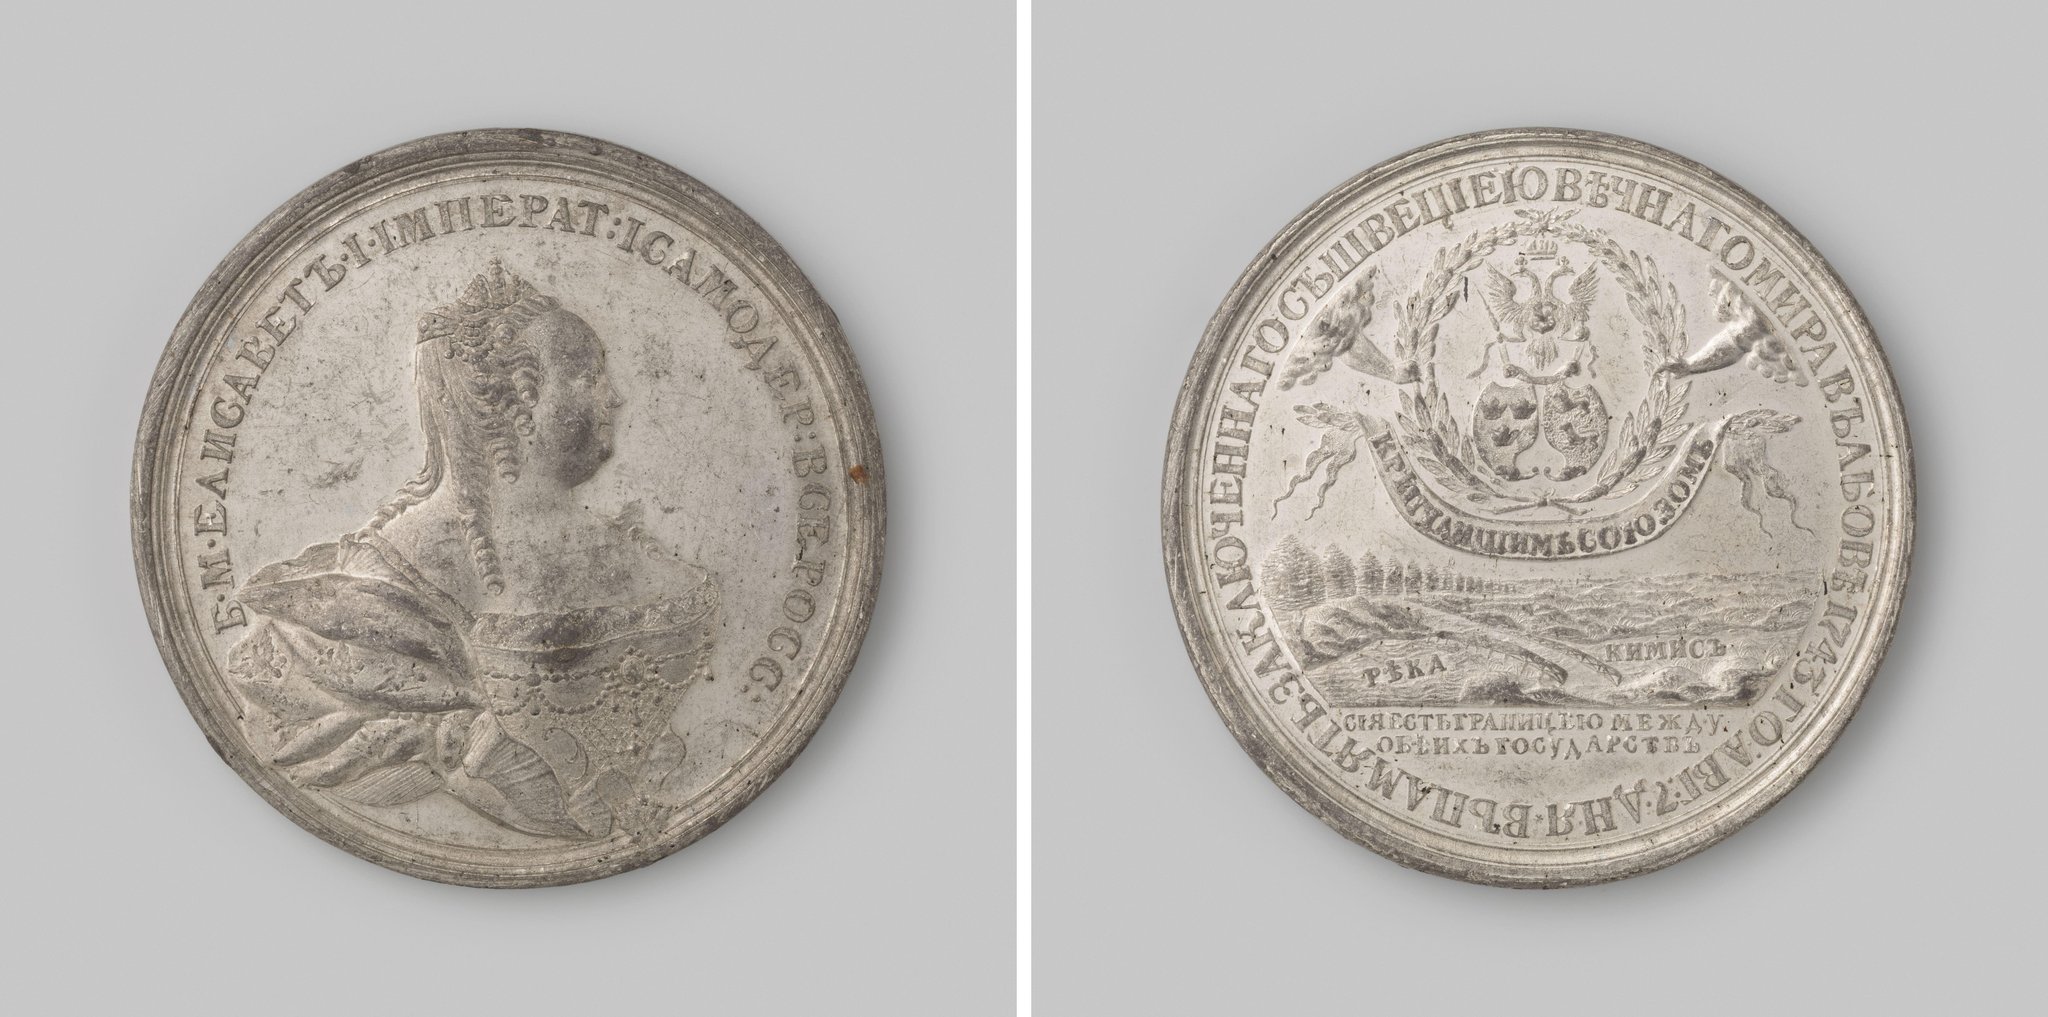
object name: history medal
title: Vrede van Abo tussen Rusland en Zweden 1743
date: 1743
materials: tin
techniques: striking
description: Tinnen penning, op de voorzijde het borstbeeld van Tsarina Elisabeth naar rechts met omschrift, op de keerzijde een brug in een landschap waarboven een adelaar op twee wapenschilden tussen twee lauwertakken vastgehouden door twee handen uit de wolken met daaronder een banderol, met omschrift en afsnedetekst.